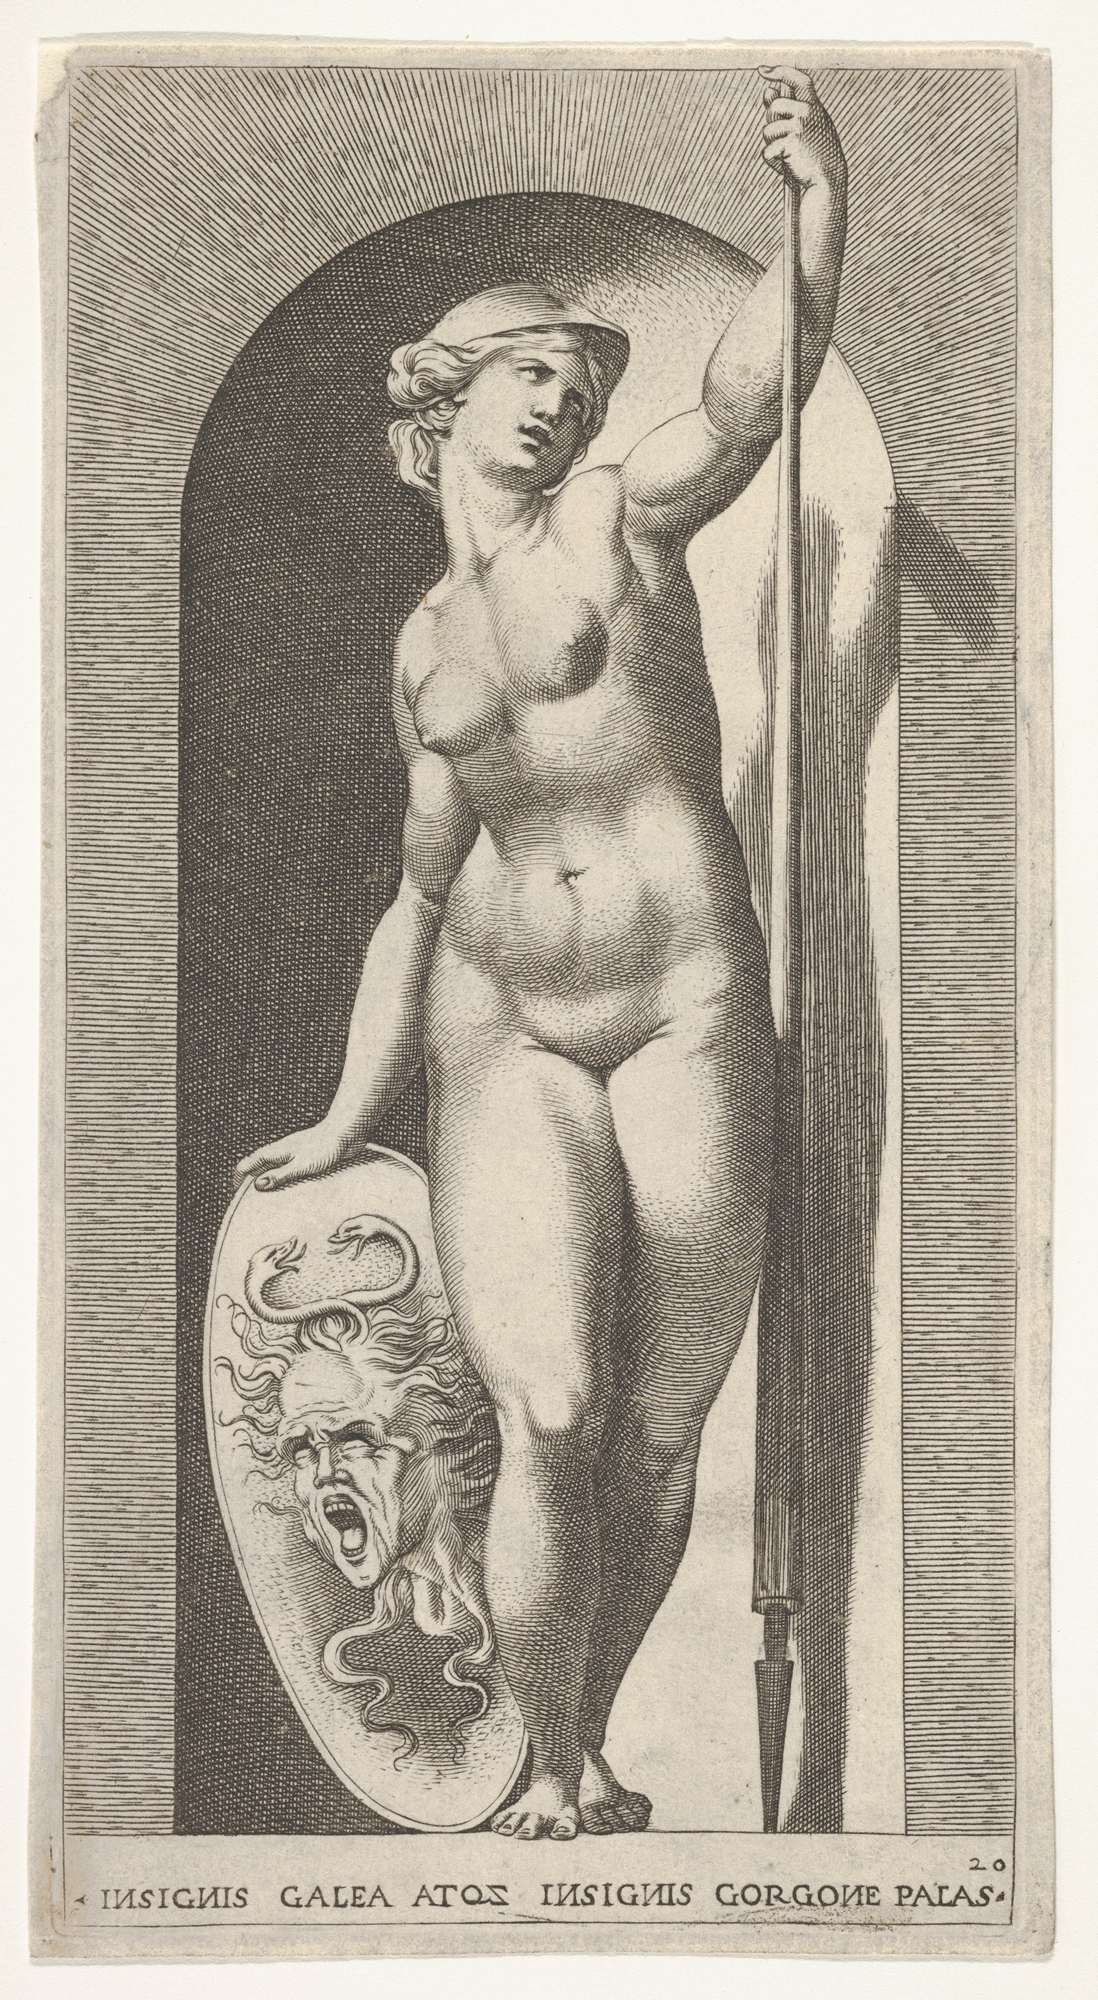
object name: print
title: Plate 20: Pallas Athena holding a shield with Medusa's head in her right hand and a lance in her left hand, from a series of mythological gods and goddesses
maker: giovanni jacopo caraglio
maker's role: artist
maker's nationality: italian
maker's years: 1500-1565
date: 1526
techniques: engraving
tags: shields,heads,athena,medusa